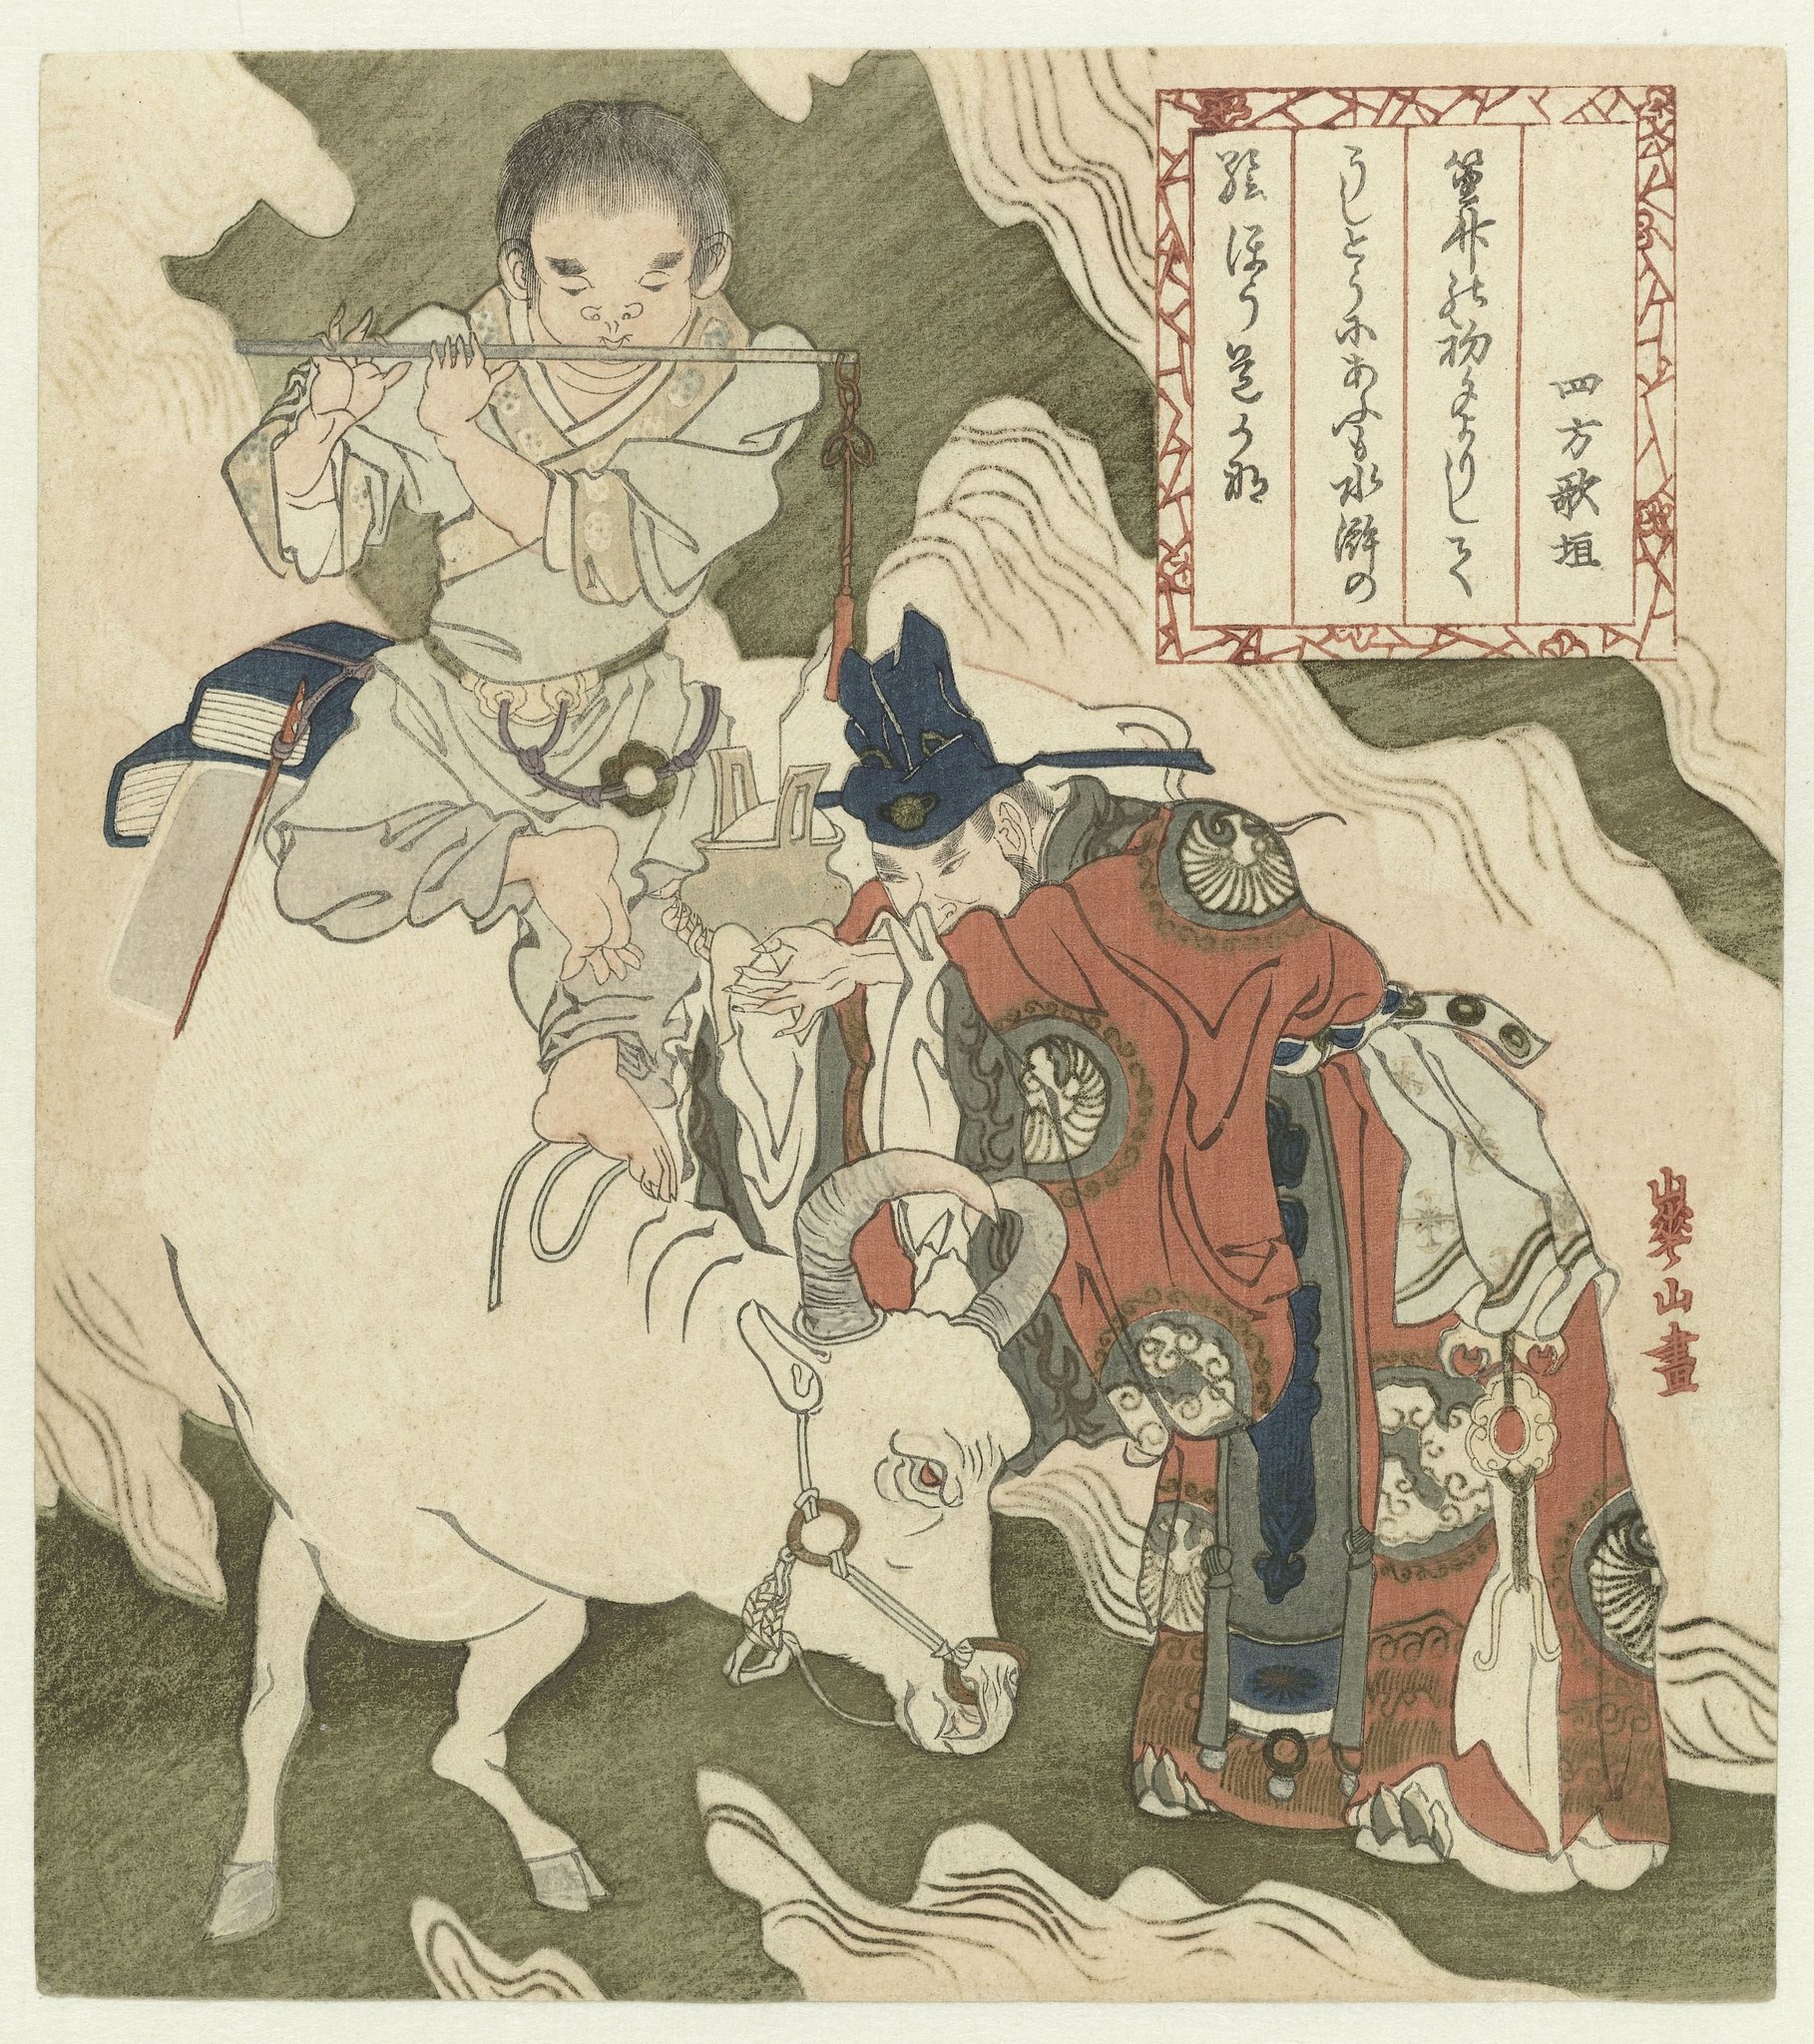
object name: surimono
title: Fluitspelende jongen op os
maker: kazan watanabe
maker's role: painter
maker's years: 1793-1841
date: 1890-1900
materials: paper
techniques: blind stamped, woodcut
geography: japan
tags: ox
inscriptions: collector's mark: Lugt 2228, collector's mark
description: Een surimono is een luxe uitgevoerde prent waarop beeld met één of meerdere gedichten gecombineerd is. Bij het drukken van een surimono werd vaak gebruik gemaakt van dikker papier, blinddruk en metaal pigmenten, zoals koper- en zilverpoeder. De prenten werden vaak in opdracht van dichters gemaakt en als exclusief geschenk aan vrienden en relaties gegeven.